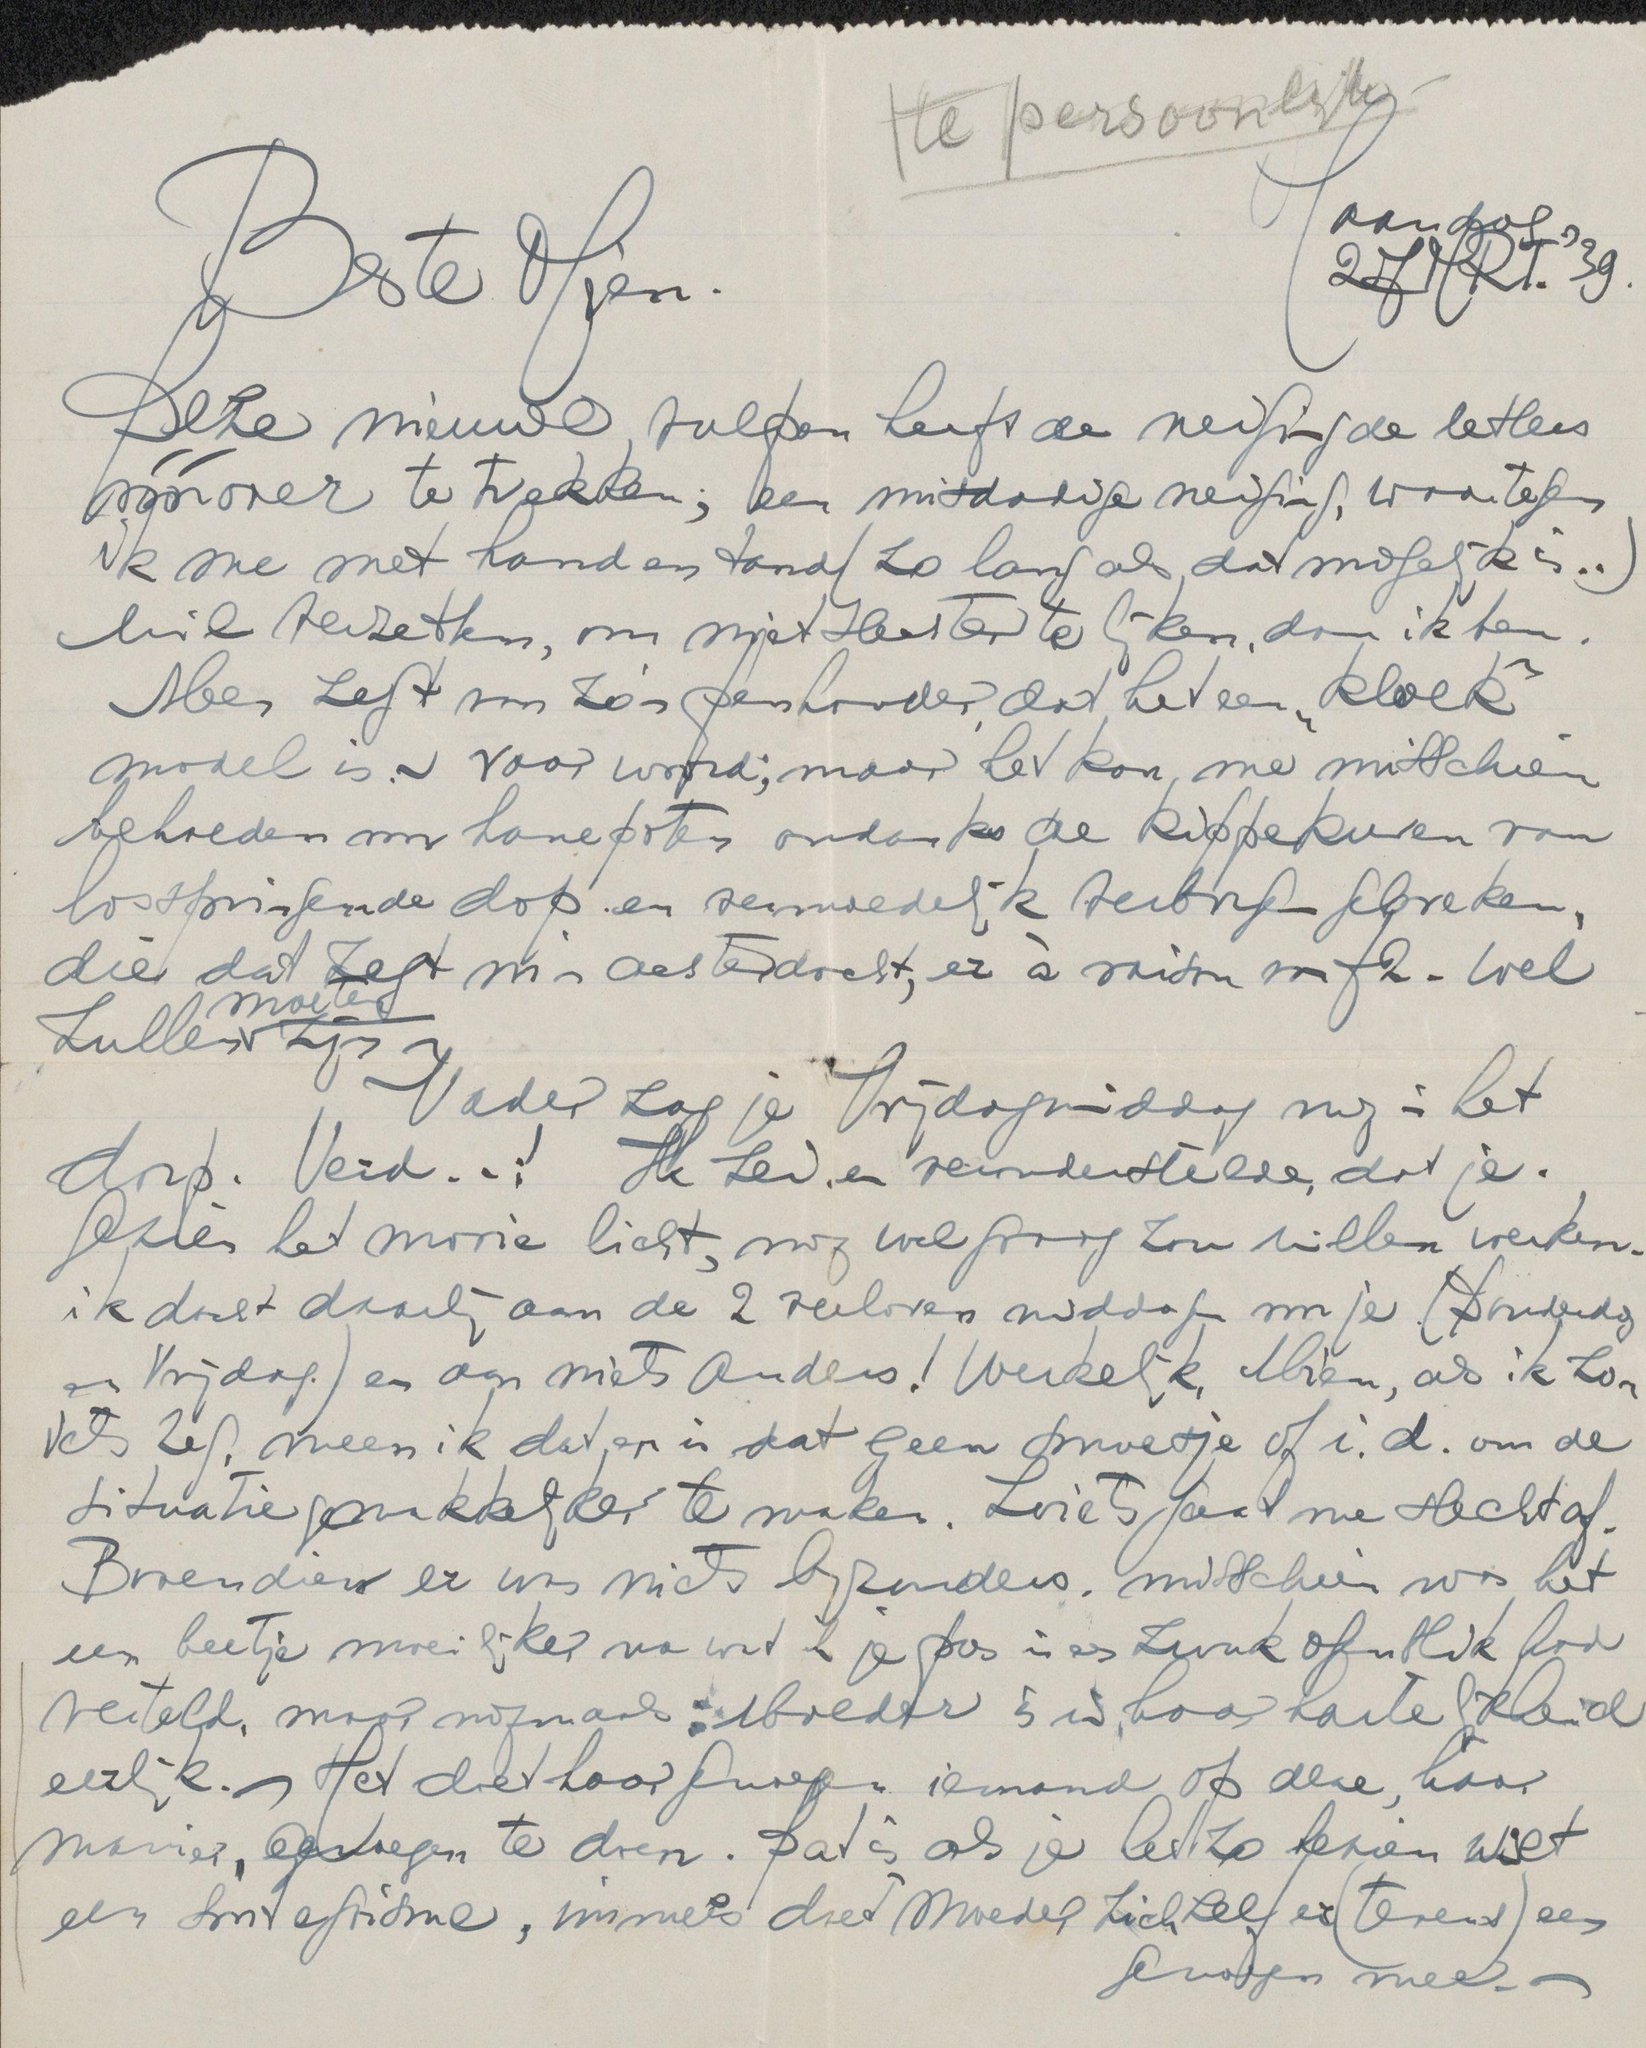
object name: letter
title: Brief aan Mien Cambier van Nooten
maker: dick ket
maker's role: draughtsman, print maker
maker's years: 1902-1940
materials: ink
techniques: pen, writing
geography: bennekom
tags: print maker, draughtsman, mien cambier van nooten, haarlem, dollmaker, textile artist, nelly johanna hagelen-schilt, drawing, passions, emotions, affections, family life, painting (including book-illumination, miniature-painting), diseases, historical persons (portraits and scenes from the life)